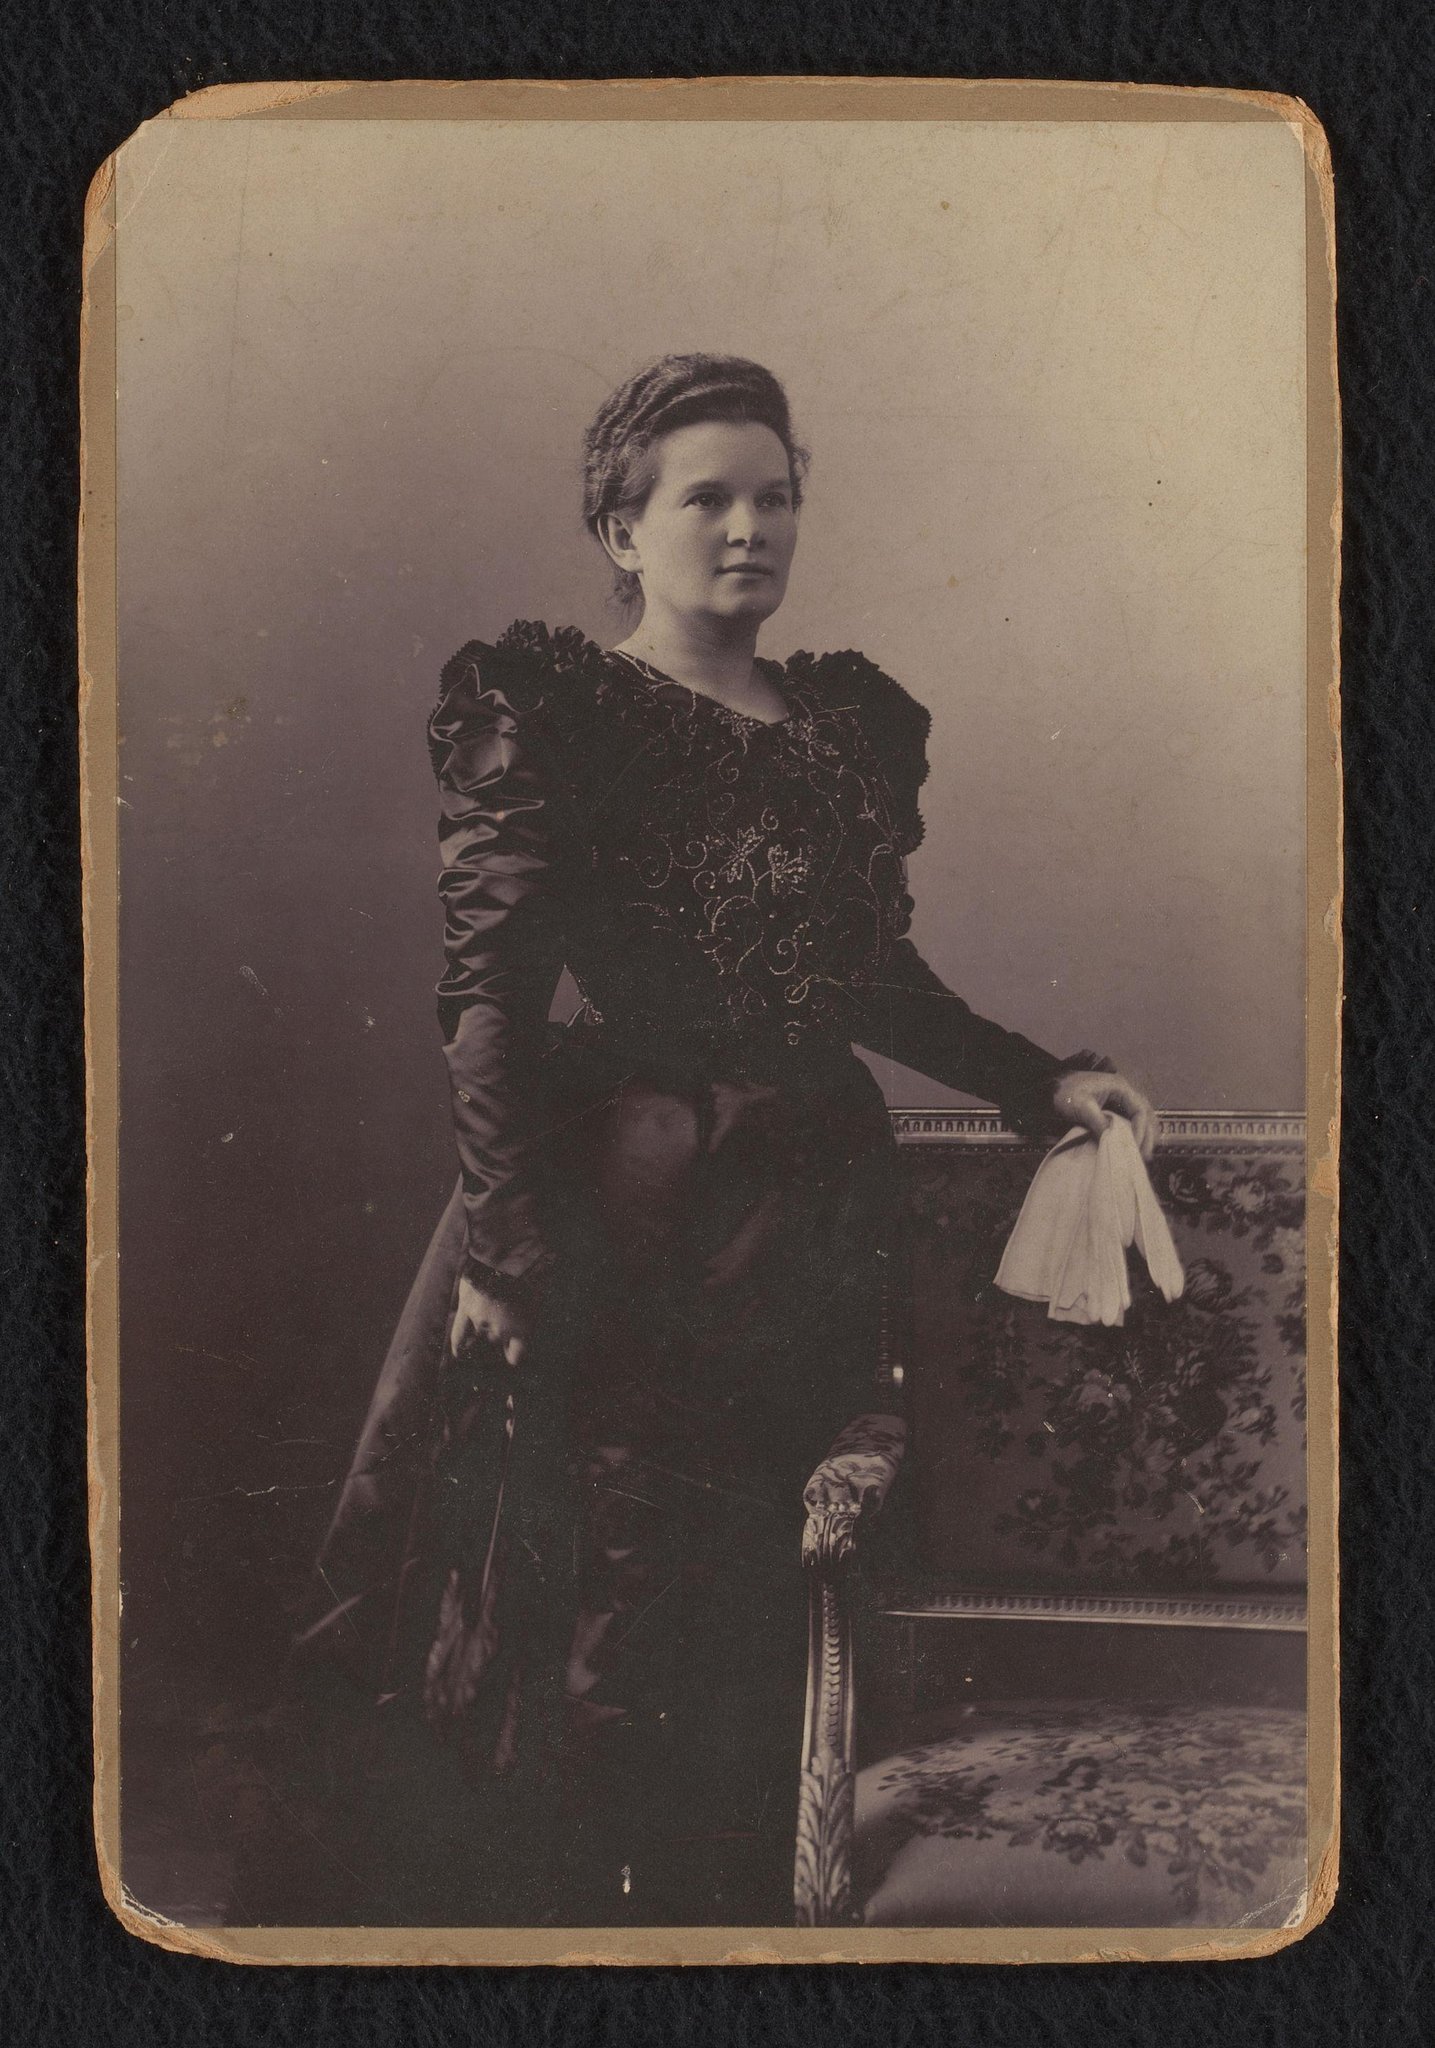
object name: cabinet photograph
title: Portret van Margo Kessler-de Lange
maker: Anonymous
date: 1880-1900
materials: cardboard, paper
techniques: albumen print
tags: margaretha jacoba johanna kessler-de lange (margo), historical persons - bb - woman